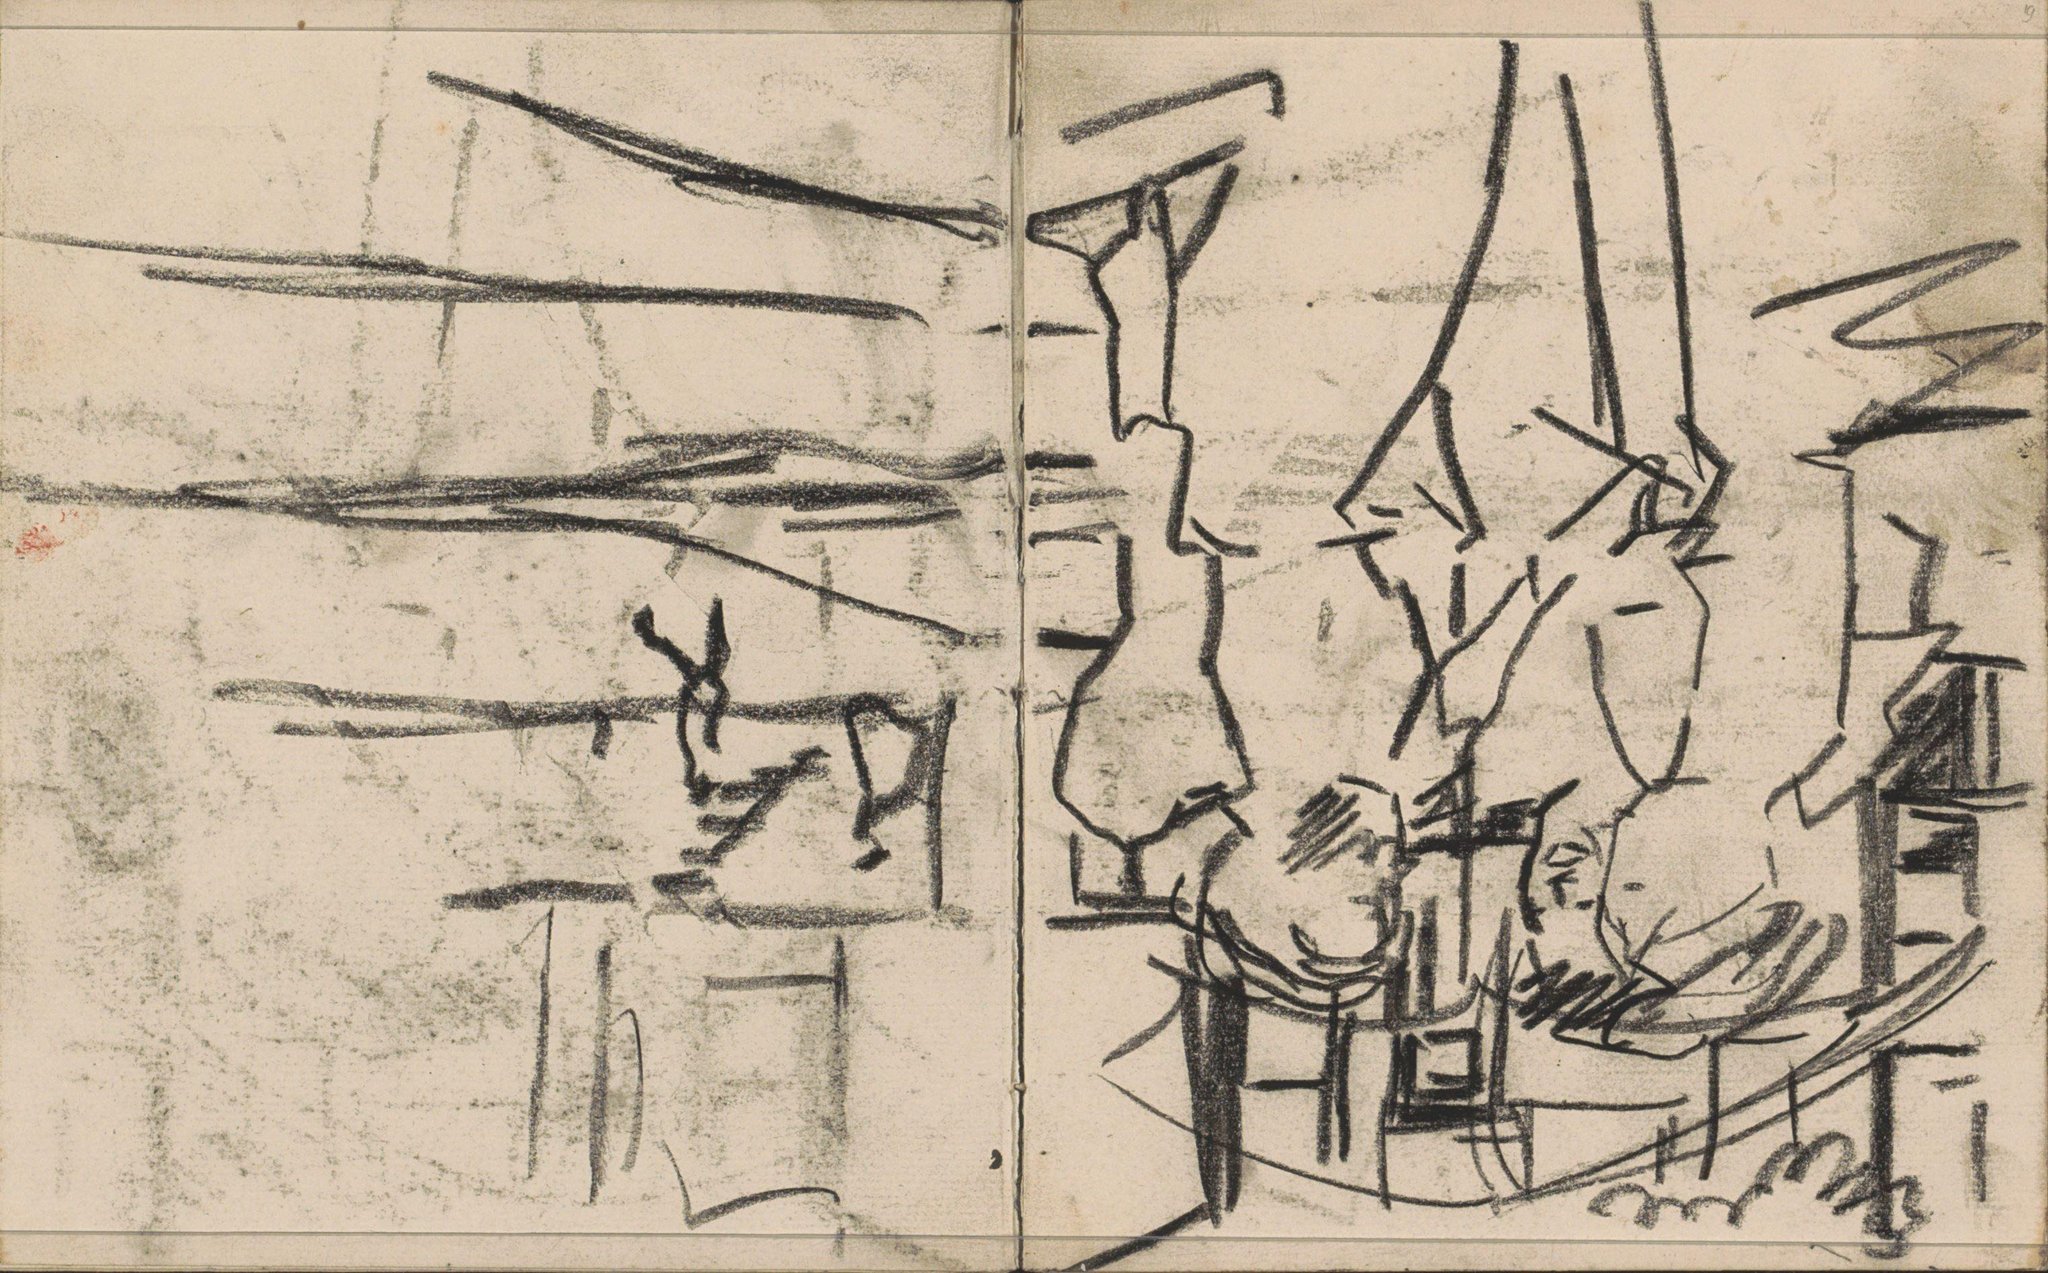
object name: sketchbook leaf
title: Drie vrouwen op straat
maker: isaac israels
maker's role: draughtsman, painter, print maker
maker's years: 1865-1934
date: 1886-1903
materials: chalk, paper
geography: amsterdam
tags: adult woman, street (+ city(-scape) with figures, staffage)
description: Mogelijk op de Leidsegracht te Amsterdam. Pagina 18 en pagina 19 uit schetsboek XXXII met 92 pagina's.